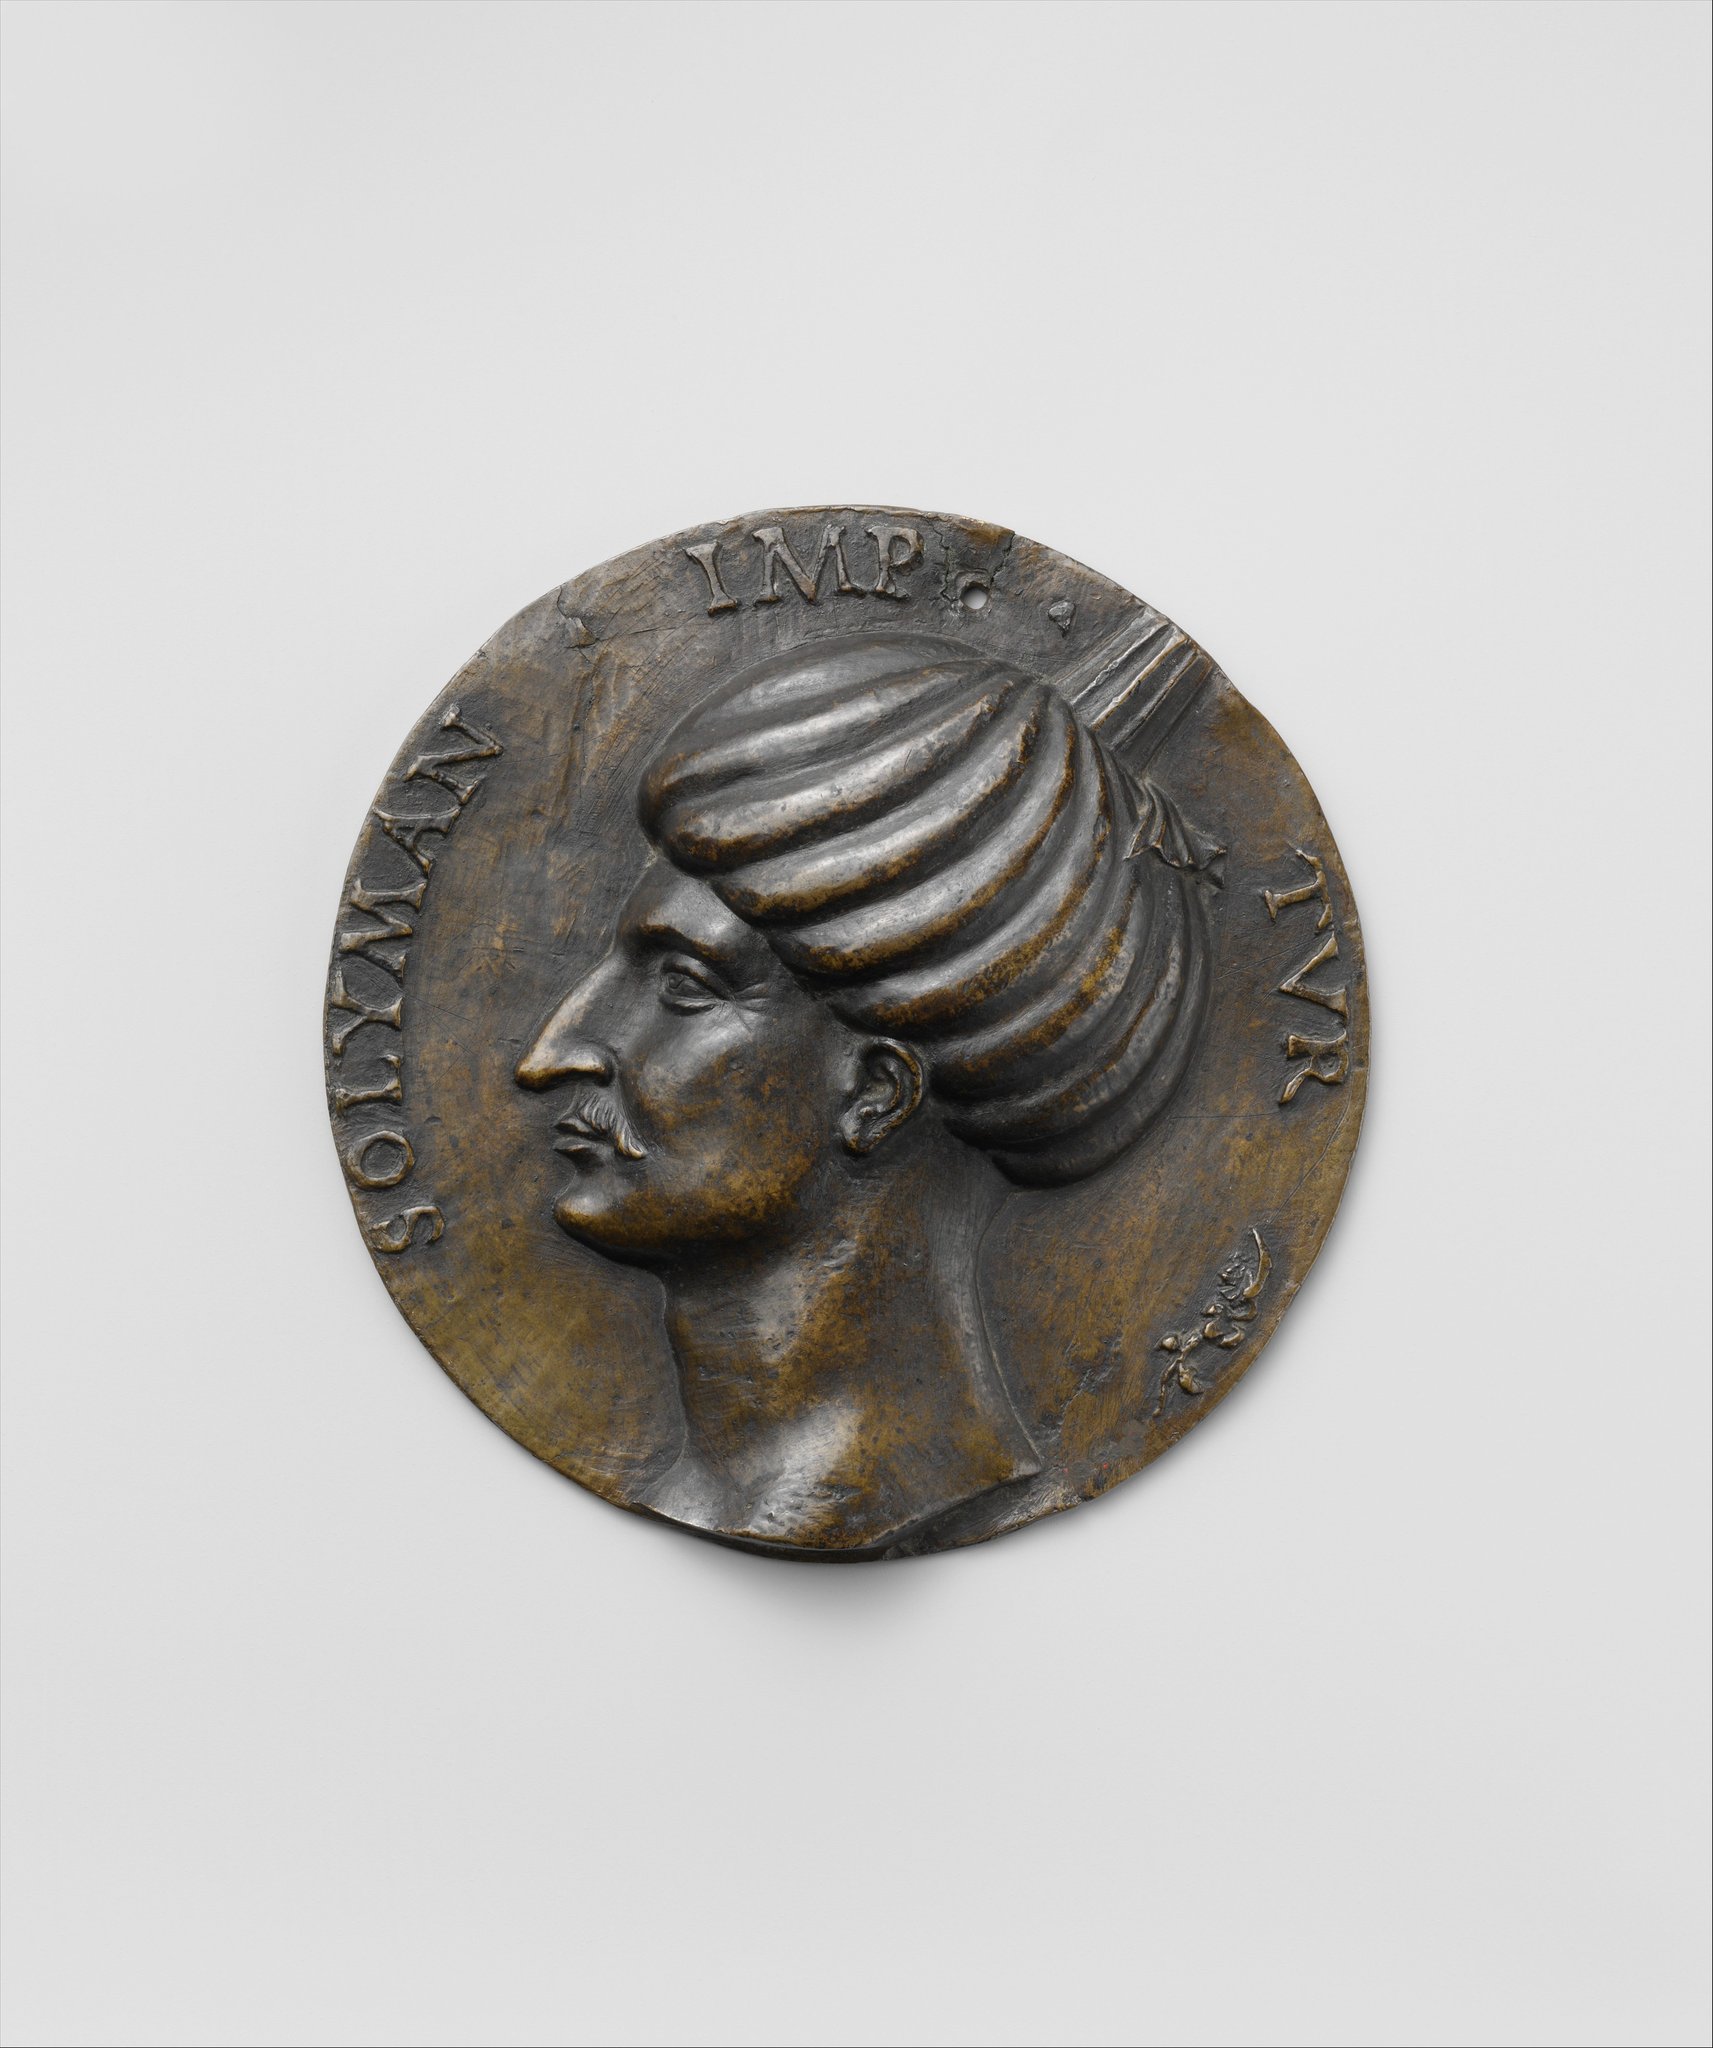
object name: medallion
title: Sulaiman the Magnificent, Sultan of Turkey (1520–1566)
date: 1520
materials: bronze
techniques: casting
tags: men,profiles